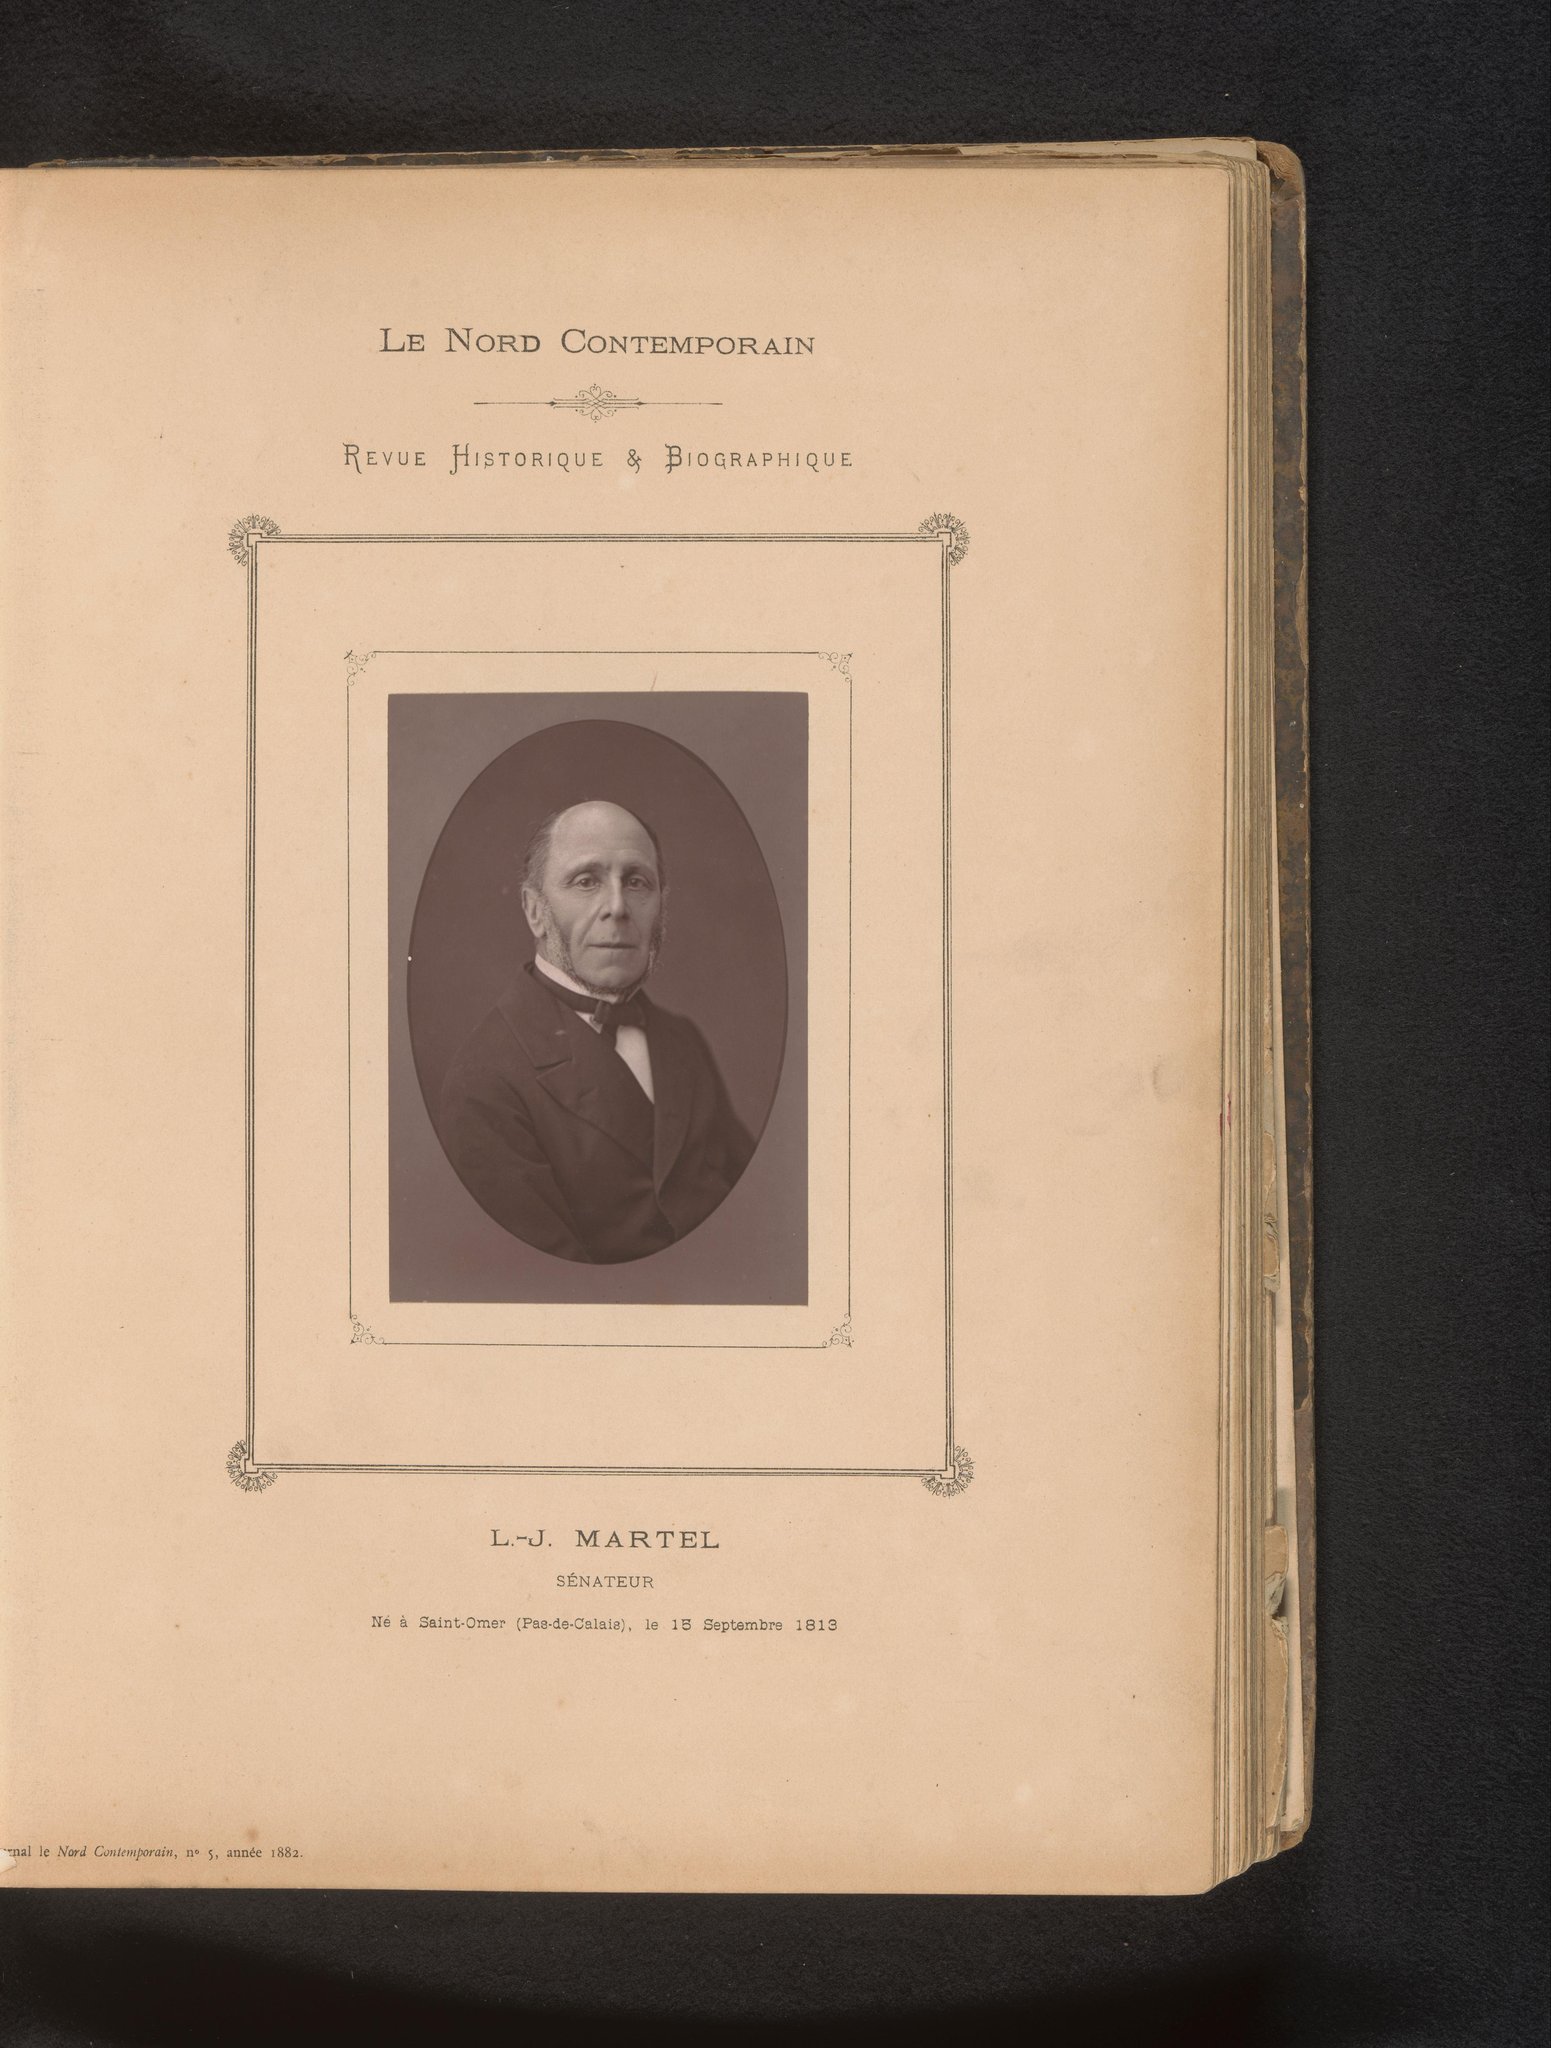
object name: page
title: L.-J. Martel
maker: Anonymous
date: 1878-1882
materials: paper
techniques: woodburytype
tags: historical persons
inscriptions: inscription: ‘Journal le Nord Contemporain, No 5, année 1882’, inscription: ‘Sénateur/ Né à Saint-Omer (Pas-de-Calais), le 15 Septembre 1813’, inscription: ‘Le Nord Contemporain/ Revue Historique & Biographique’